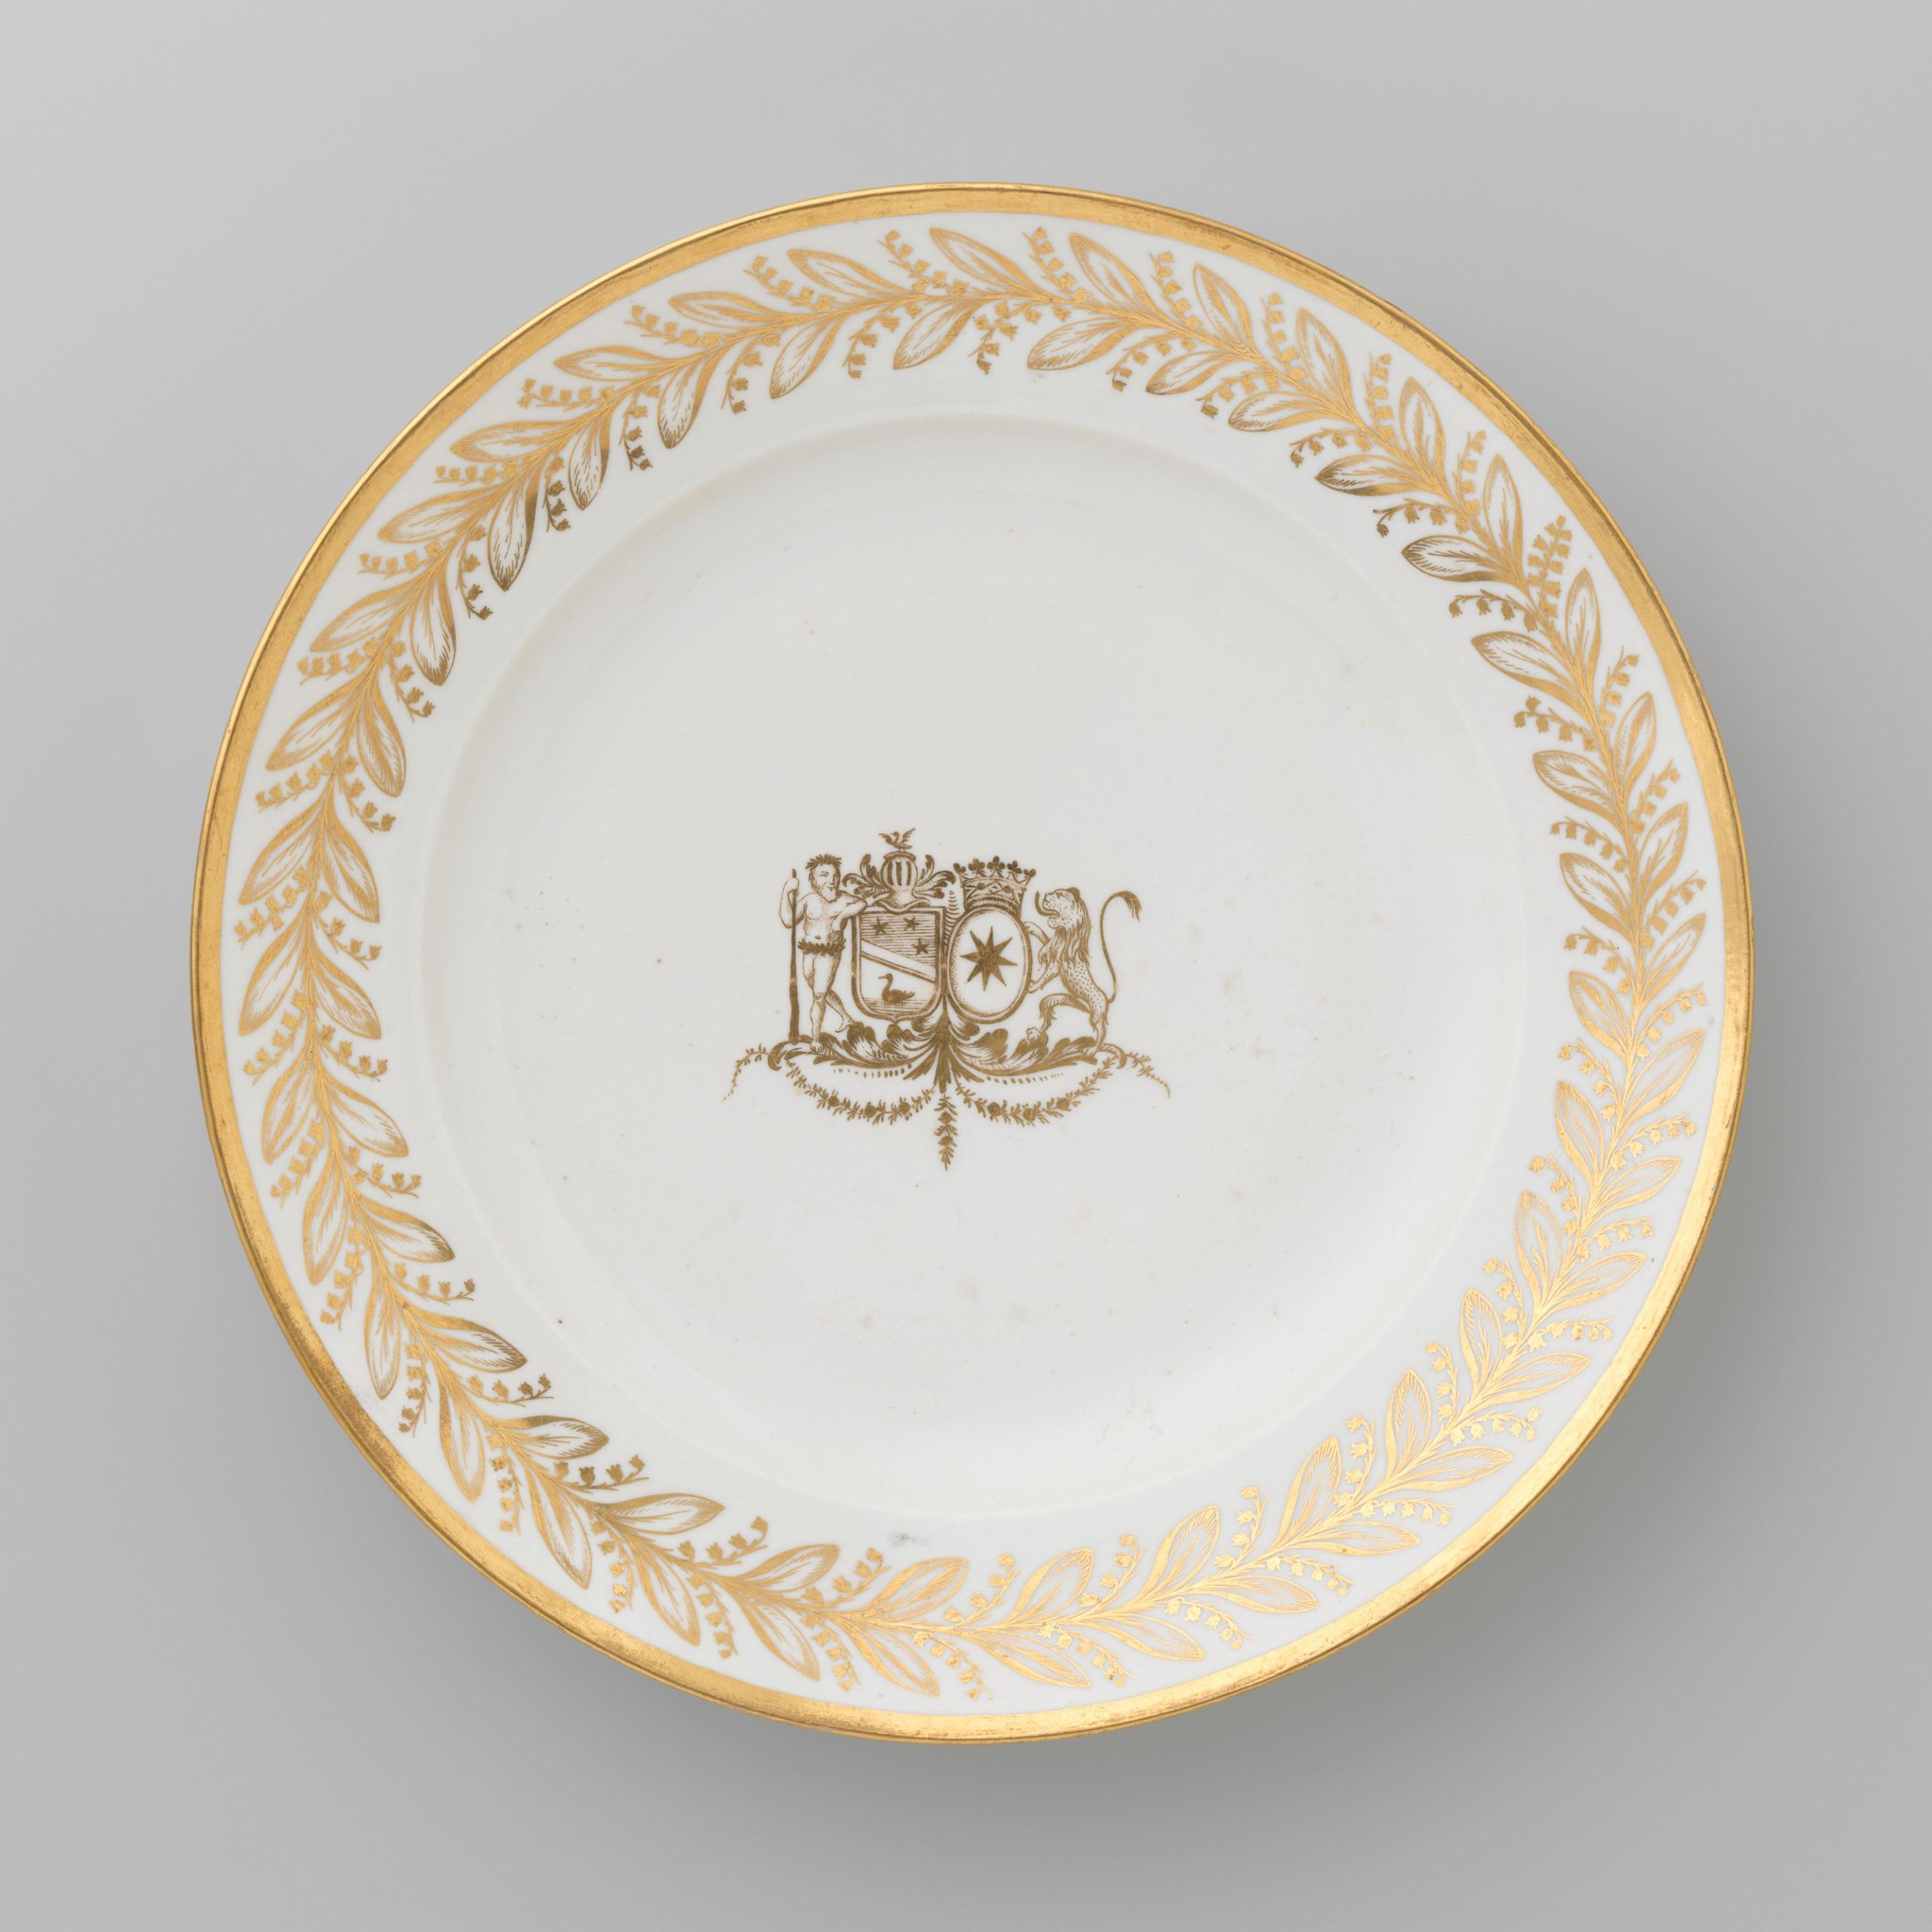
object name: platter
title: Dish with the coat of arms of Hendrik Peter Godfried Quack and Isabella Gertraud von Carnap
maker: Anonymous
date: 1790-1800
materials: glaze, gold, paint, porcelain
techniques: firing, forming, gilding, turning, vitrification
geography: paris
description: Schotel van porselein, beschilderd op het glazuur met goud. Op het plat het alliantiewapen van Hendrik Peter Godfried Quack en Isabella Gertraud von Carnap. De rand met een bloemrank en een gouden band.